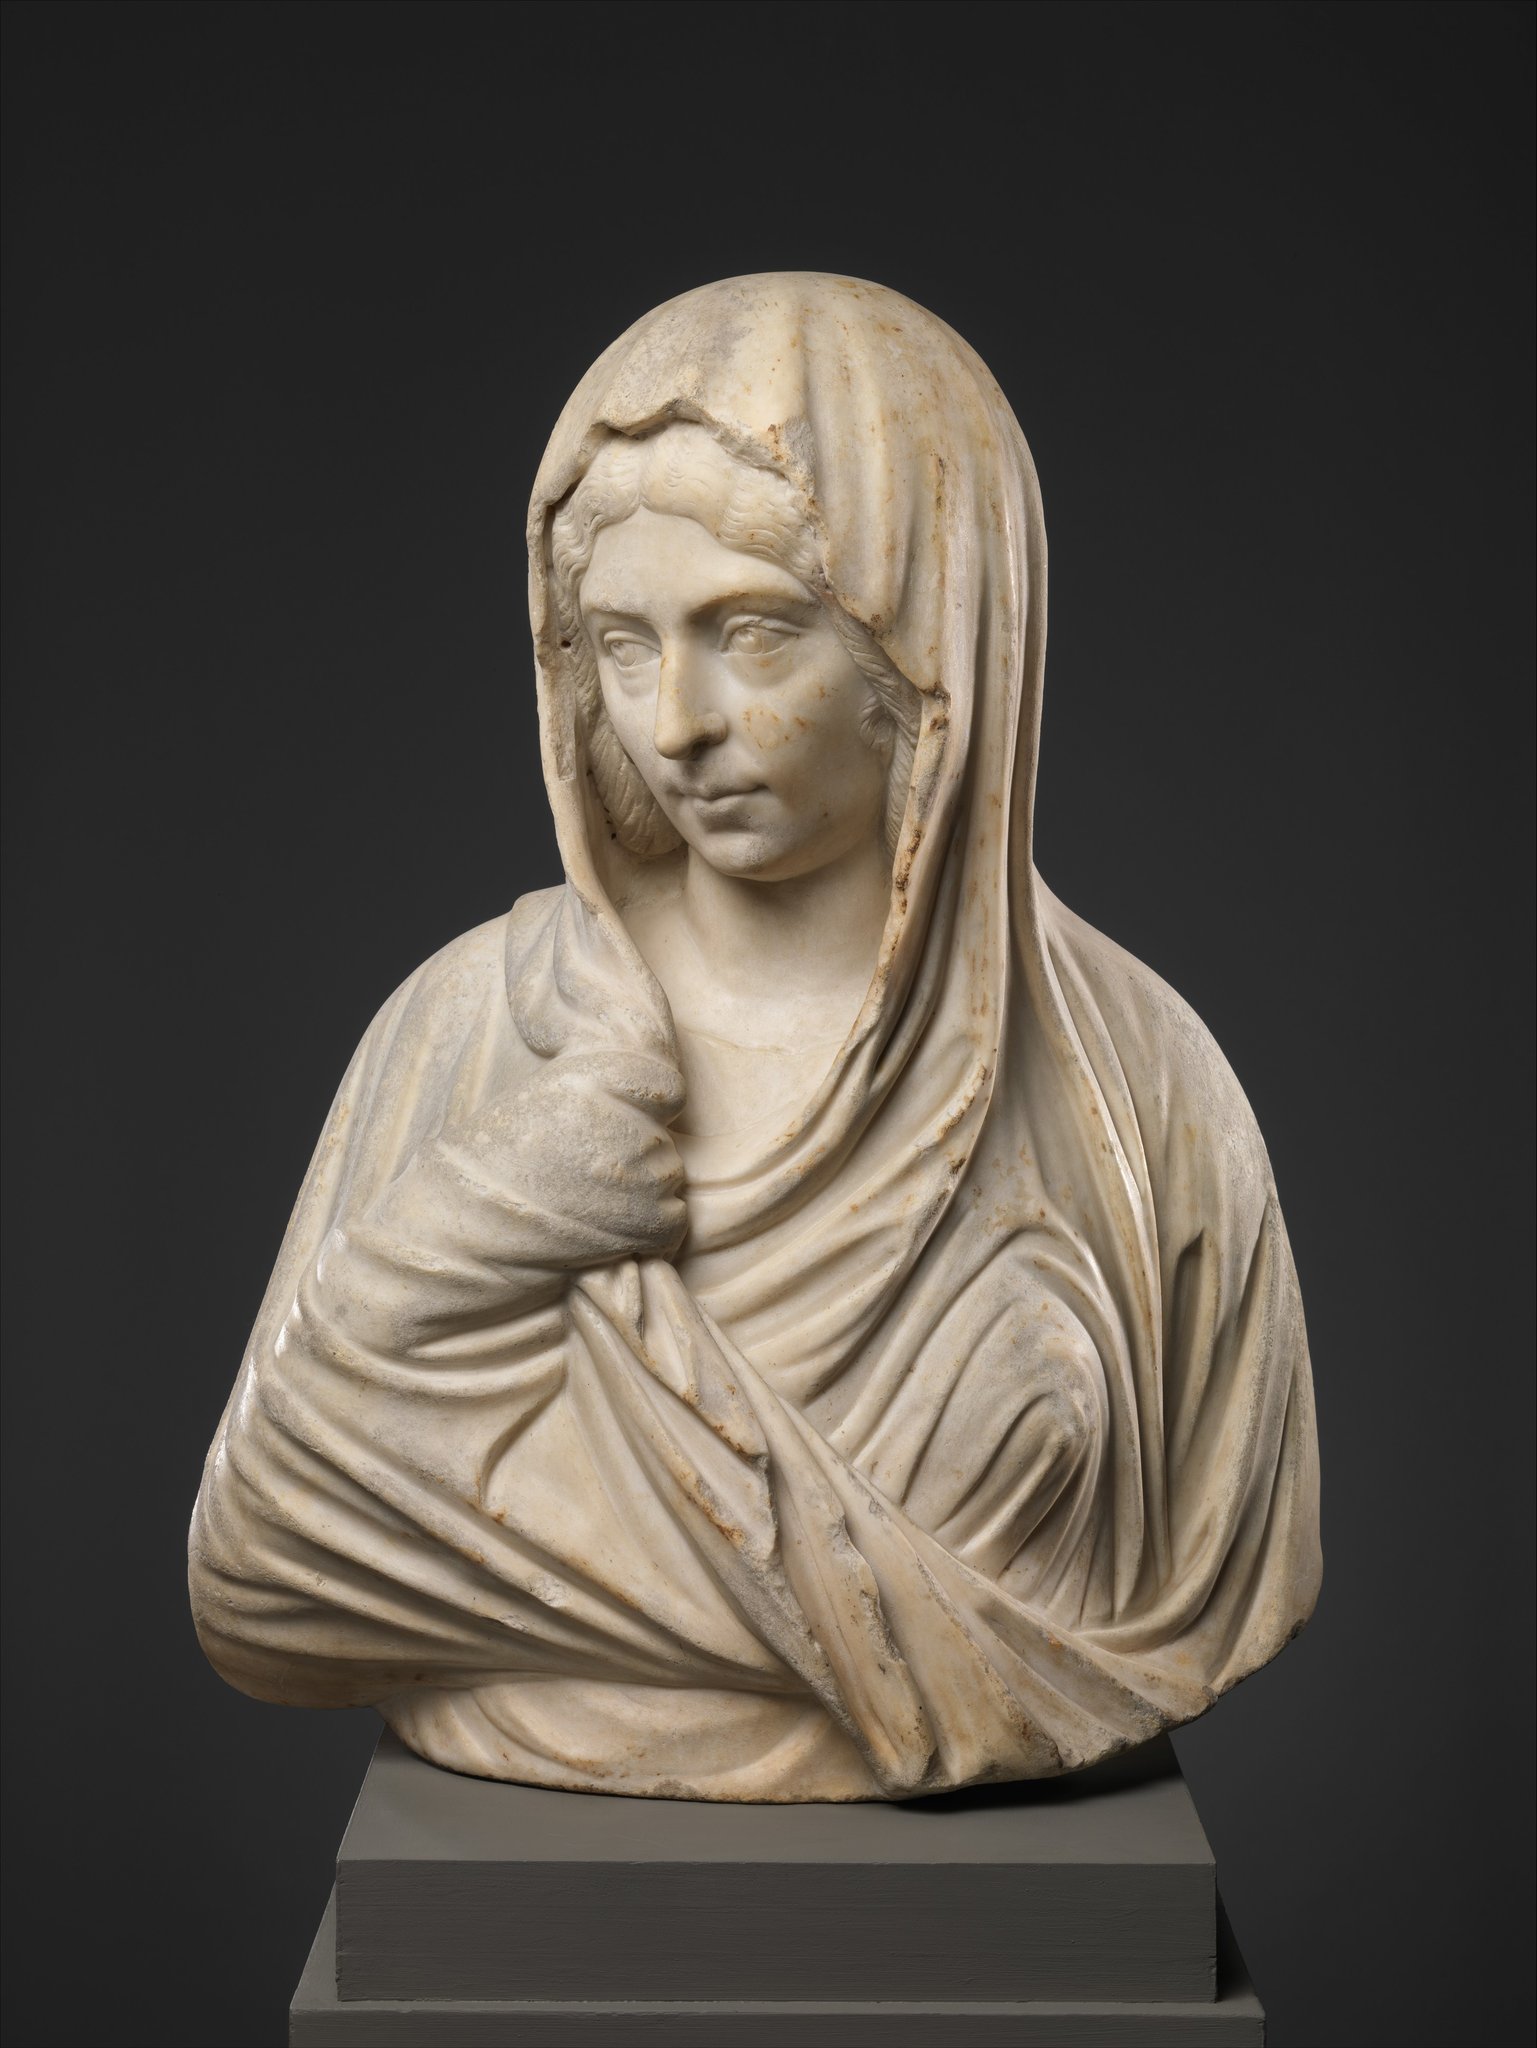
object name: portrait bust of a veiled woman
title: Marble portrait bust of a woman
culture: roman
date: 193-211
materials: marble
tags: portraits,women